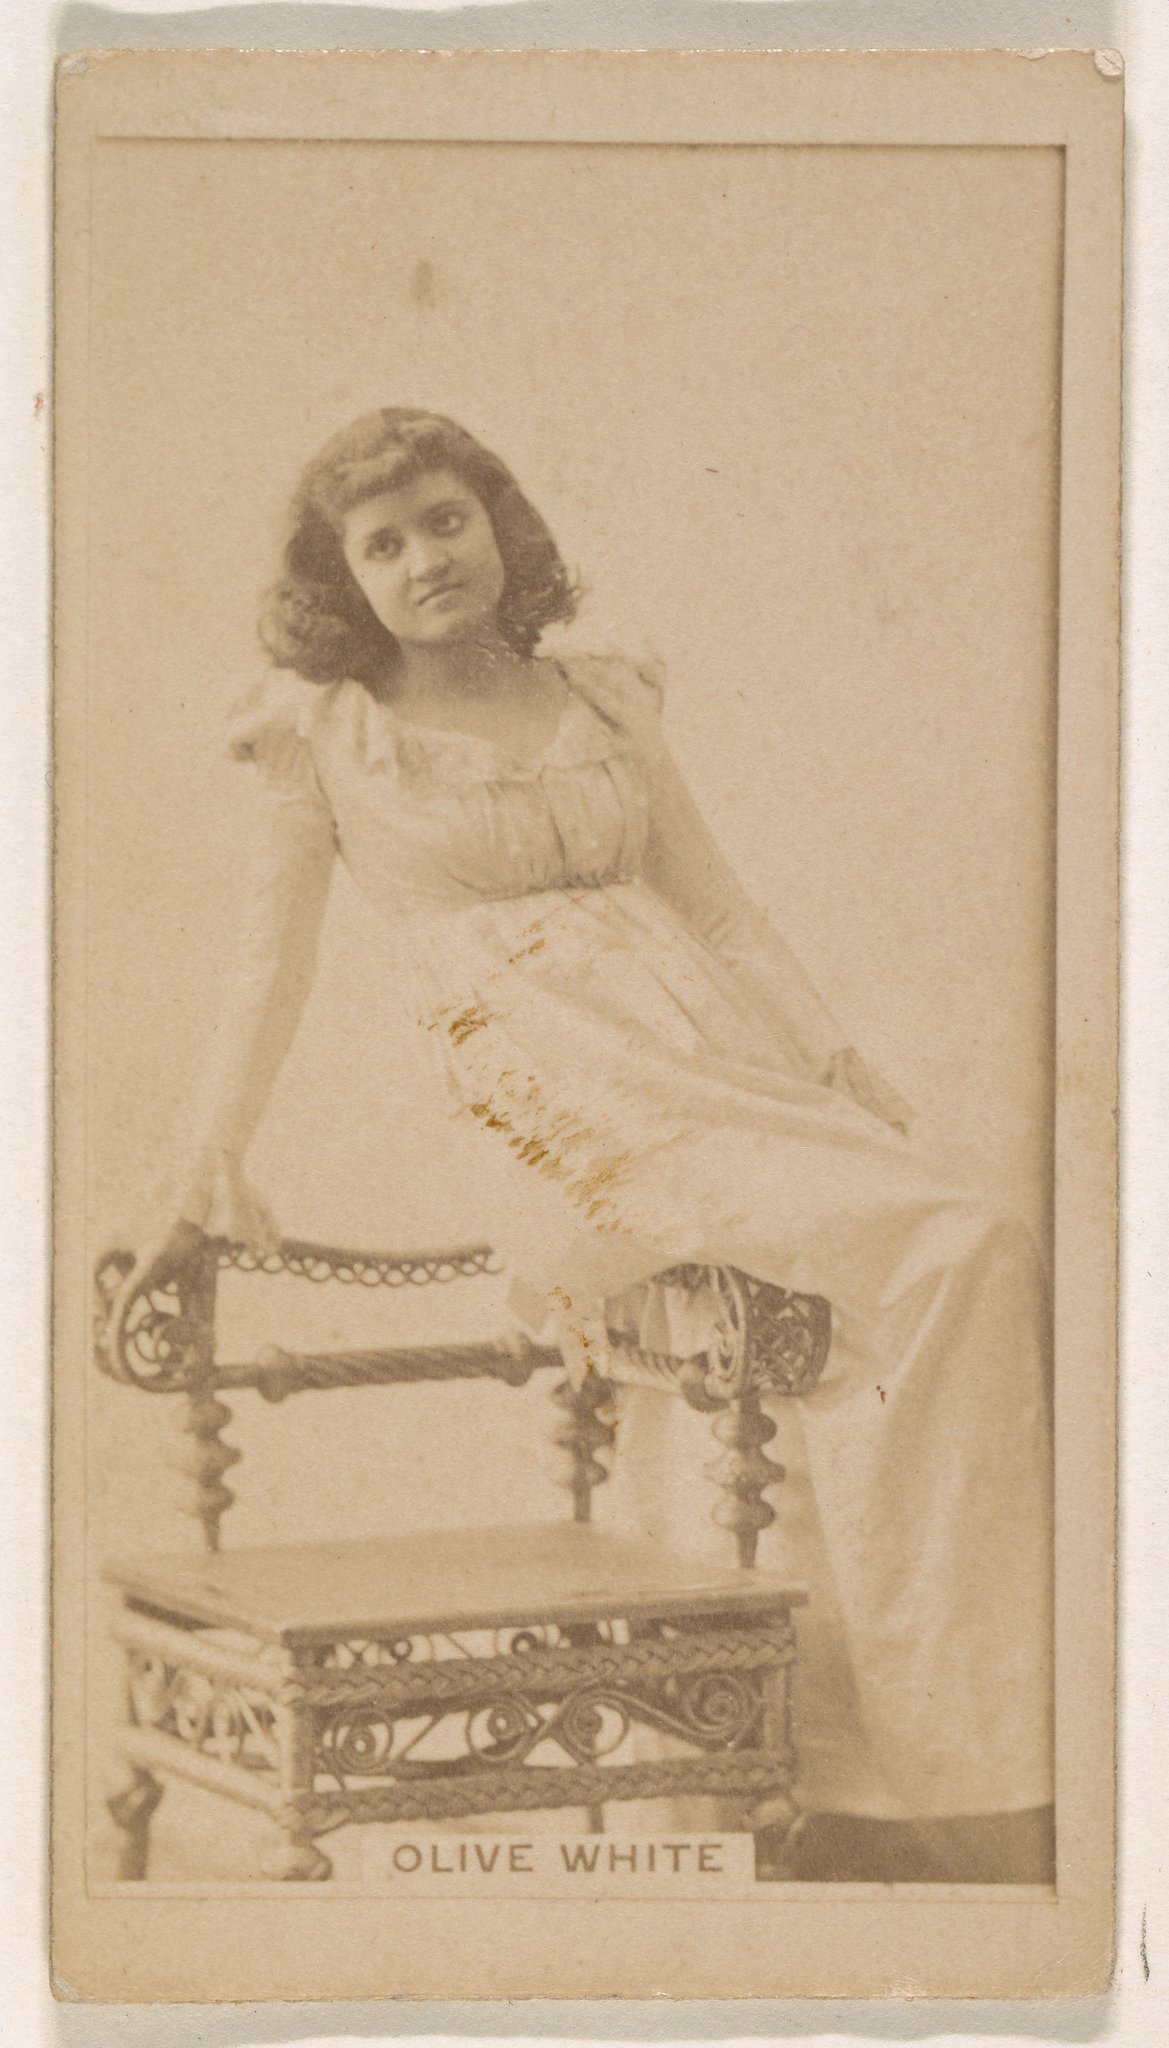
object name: photograph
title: Olive White, from the Actresses series (N245) issued by Kinney Brothers to promote Sweet Caporal Cigarettes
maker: kinney brothers tobacco company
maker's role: publisher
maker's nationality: american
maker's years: 1869-2011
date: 1890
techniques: albumen silver print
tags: portraits,women,actresses